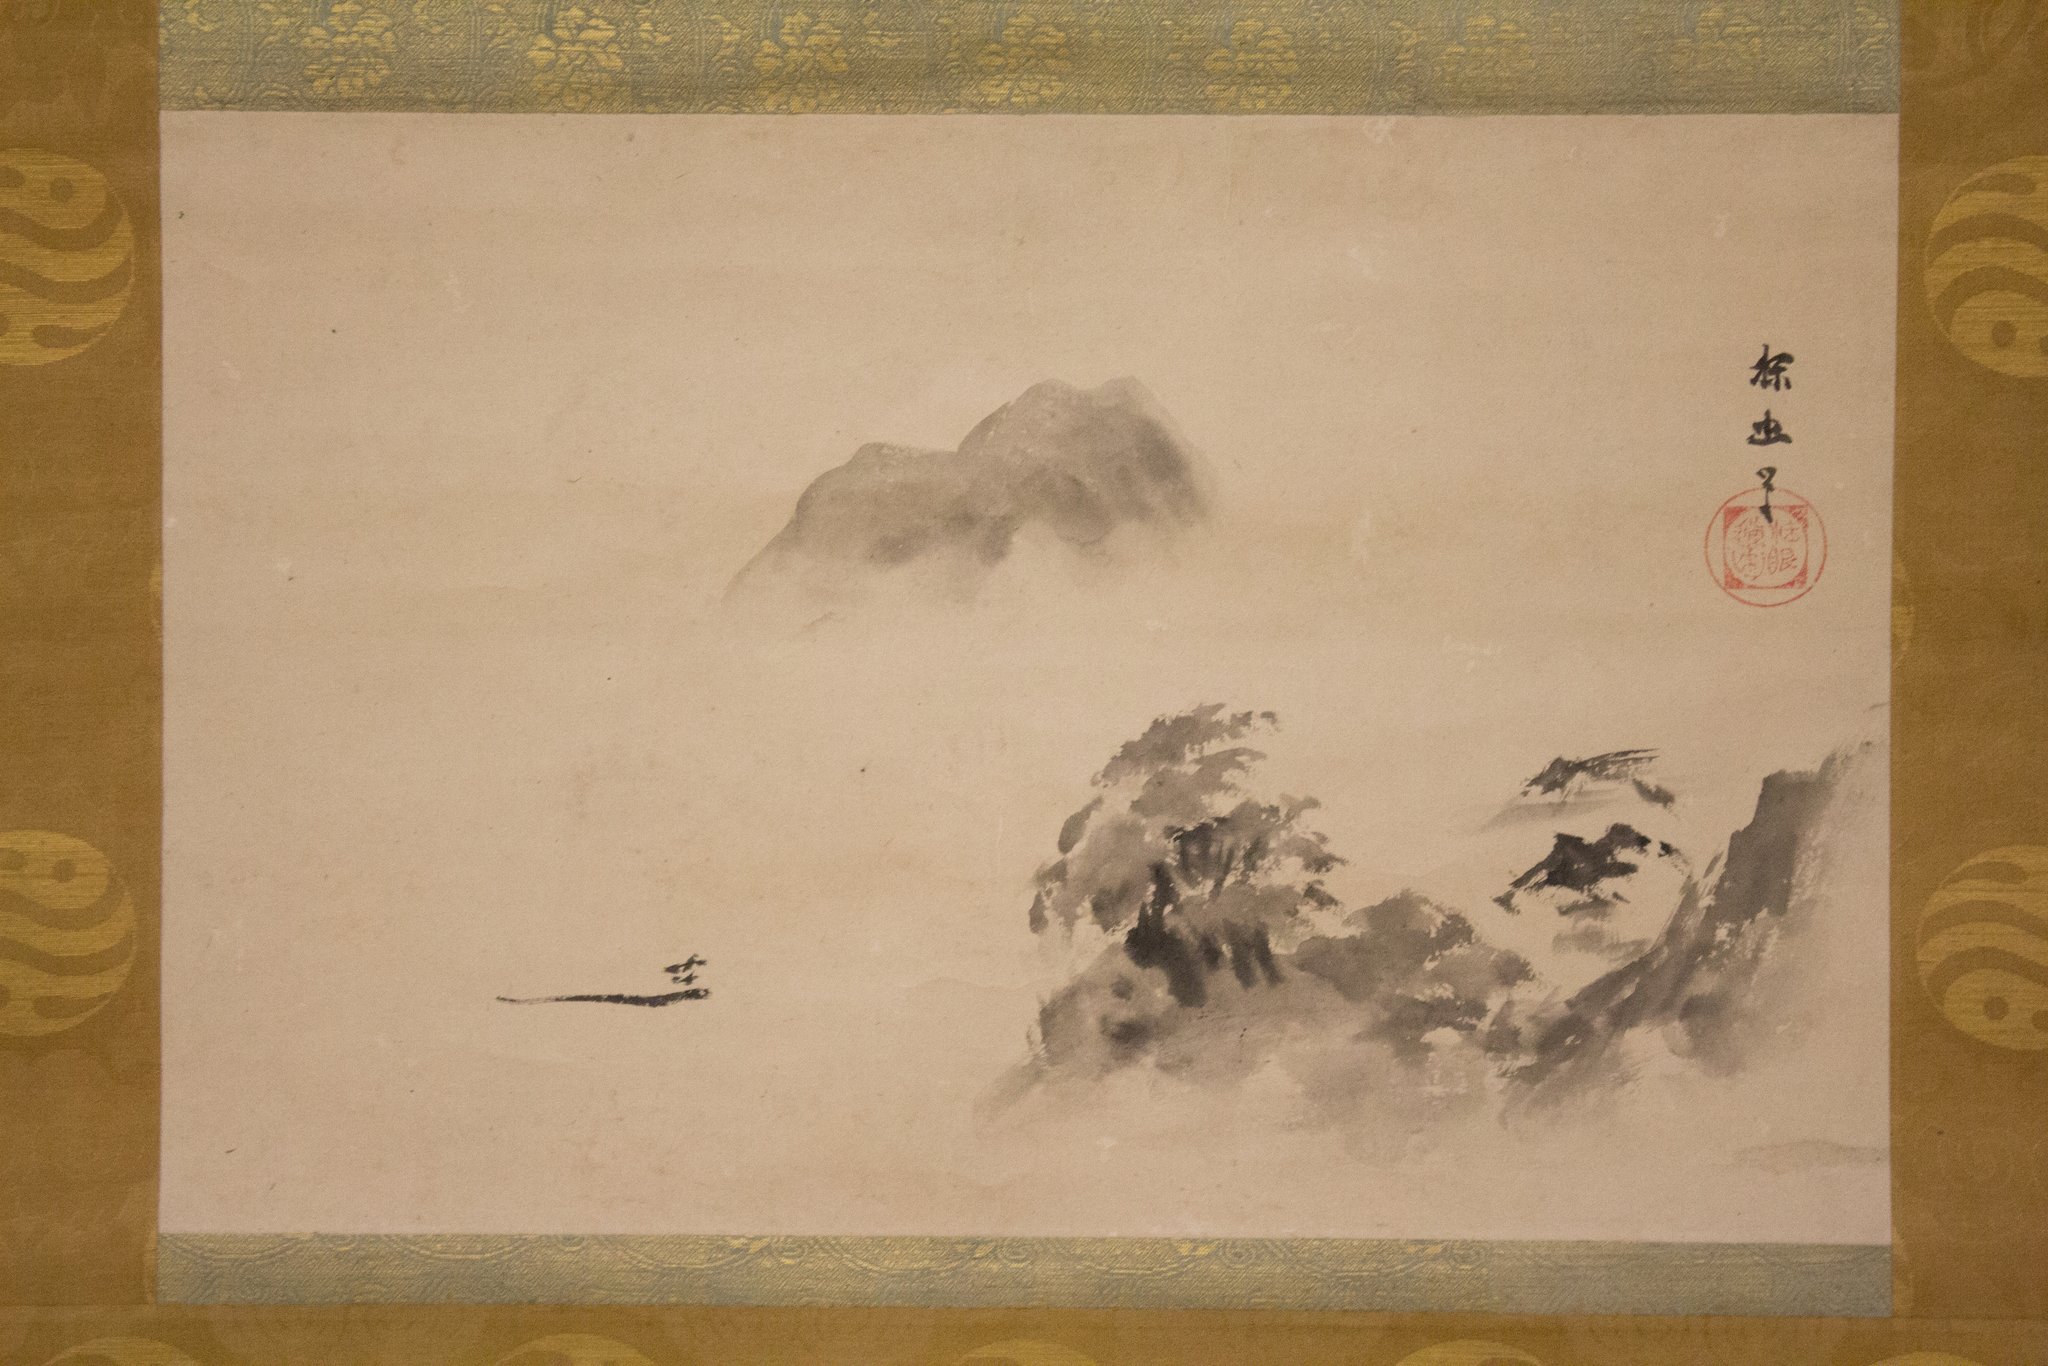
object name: hanging scroll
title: Misty Landscape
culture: japanese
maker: kano school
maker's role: artist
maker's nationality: japanese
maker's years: 1476-1559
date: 1801-1833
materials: ink, paper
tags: landscapes